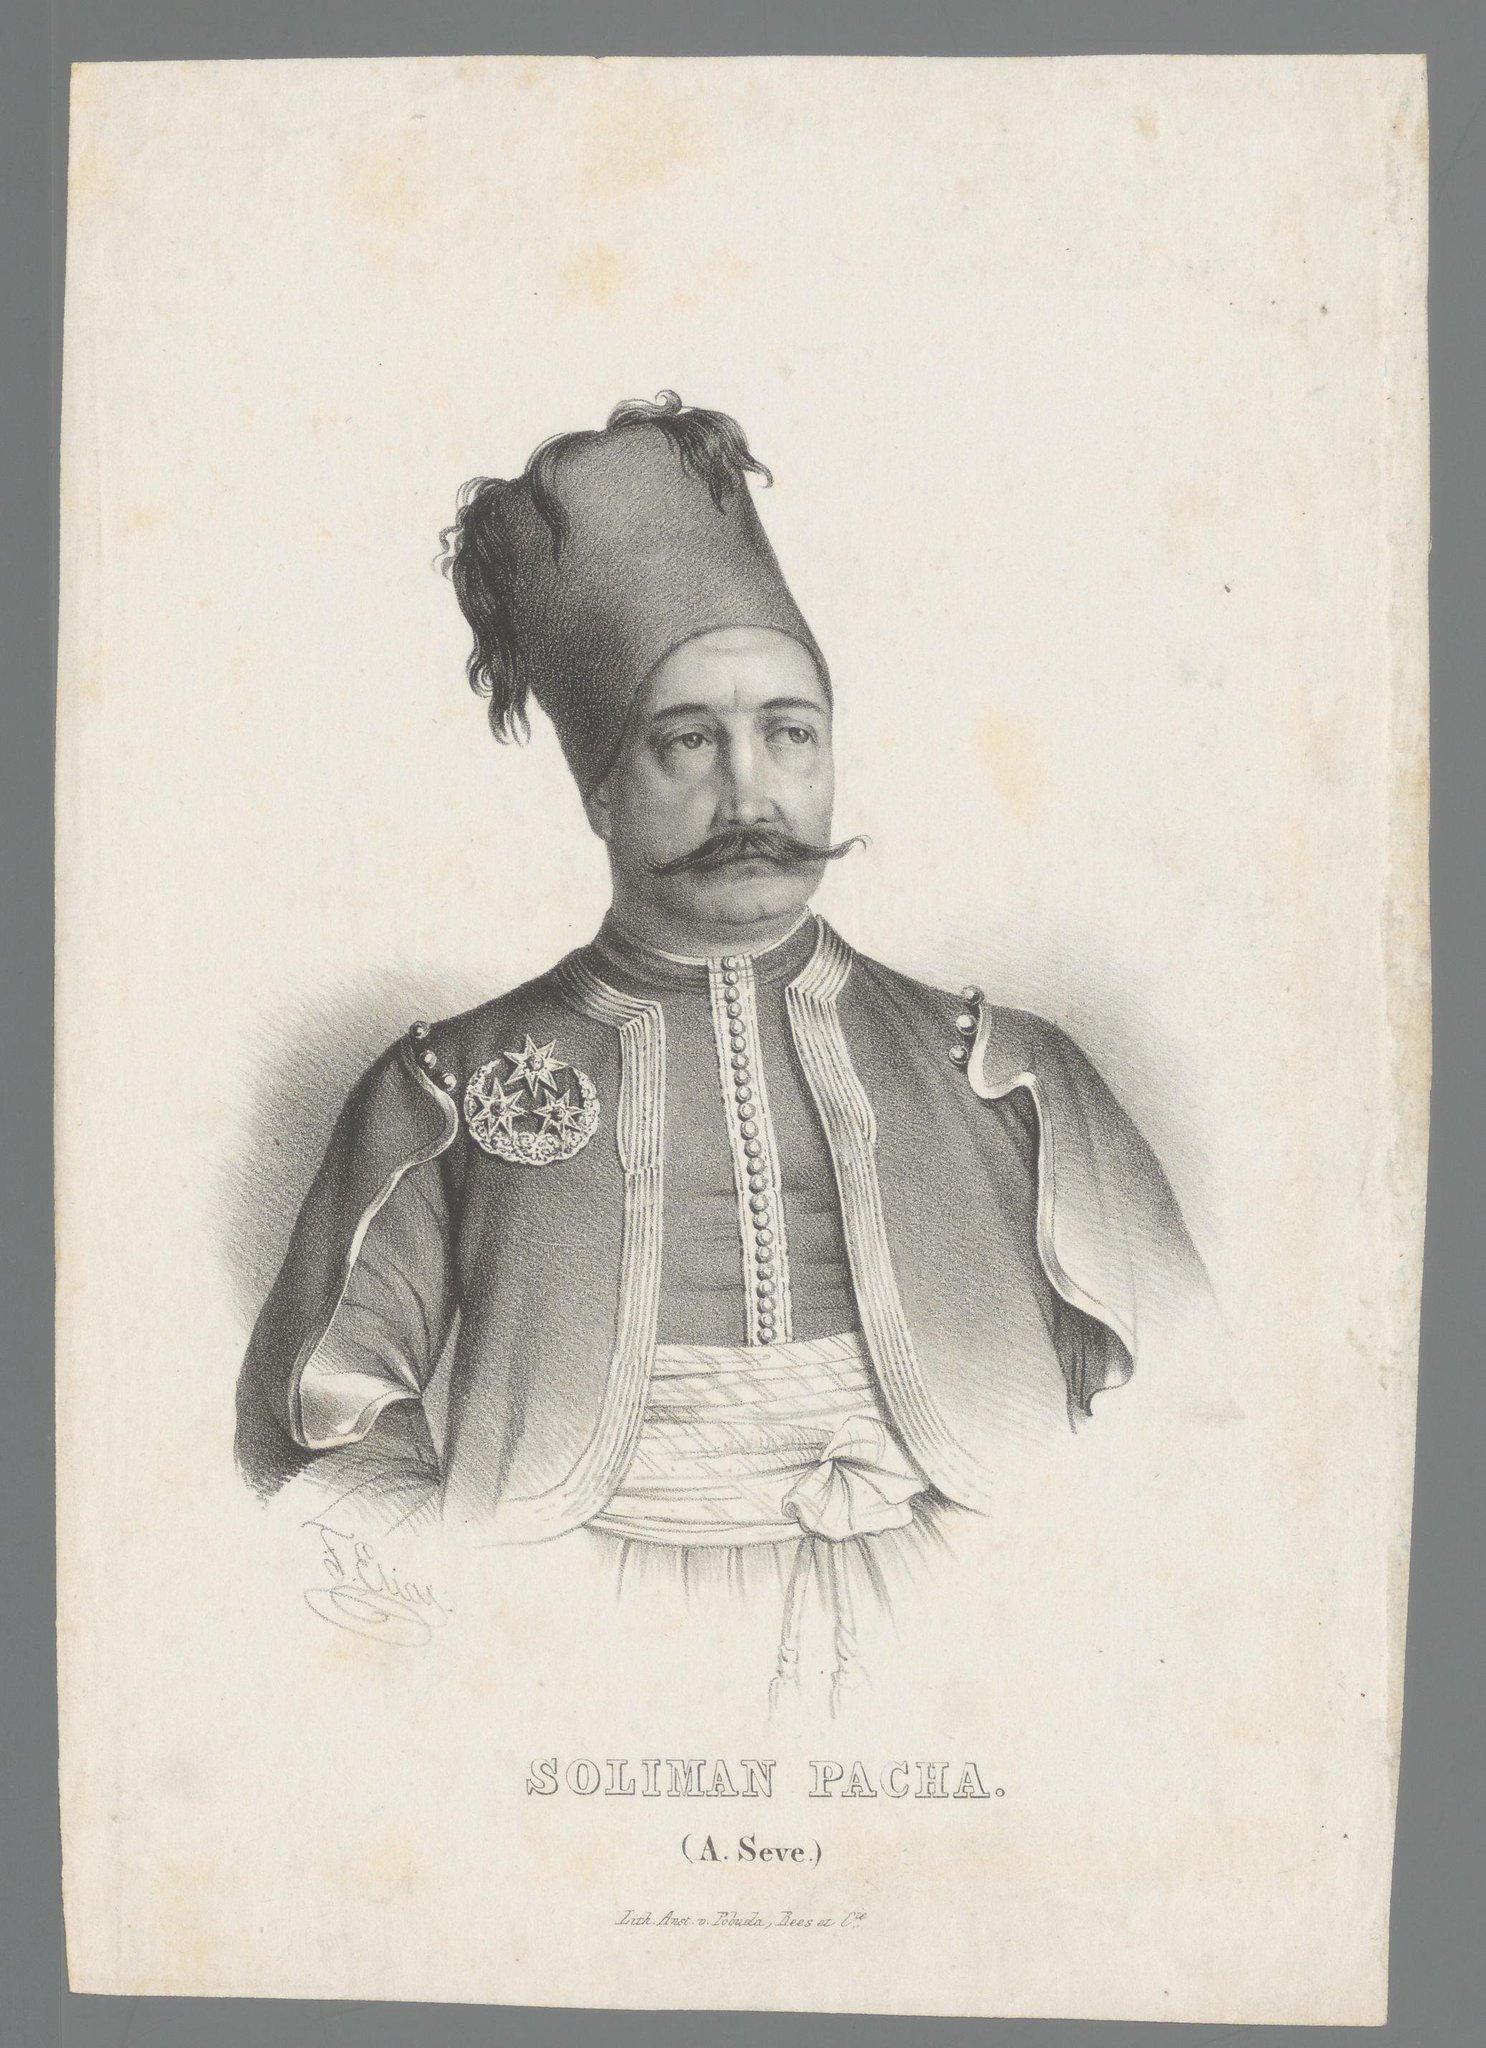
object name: print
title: Soliman Pacha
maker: f. elias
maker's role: print maker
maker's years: -1846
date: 1833-1846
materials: paper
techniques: lithograph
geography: stuttgart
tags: ranks in the army, historical persons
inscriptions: collector's mark: Lugt 2228